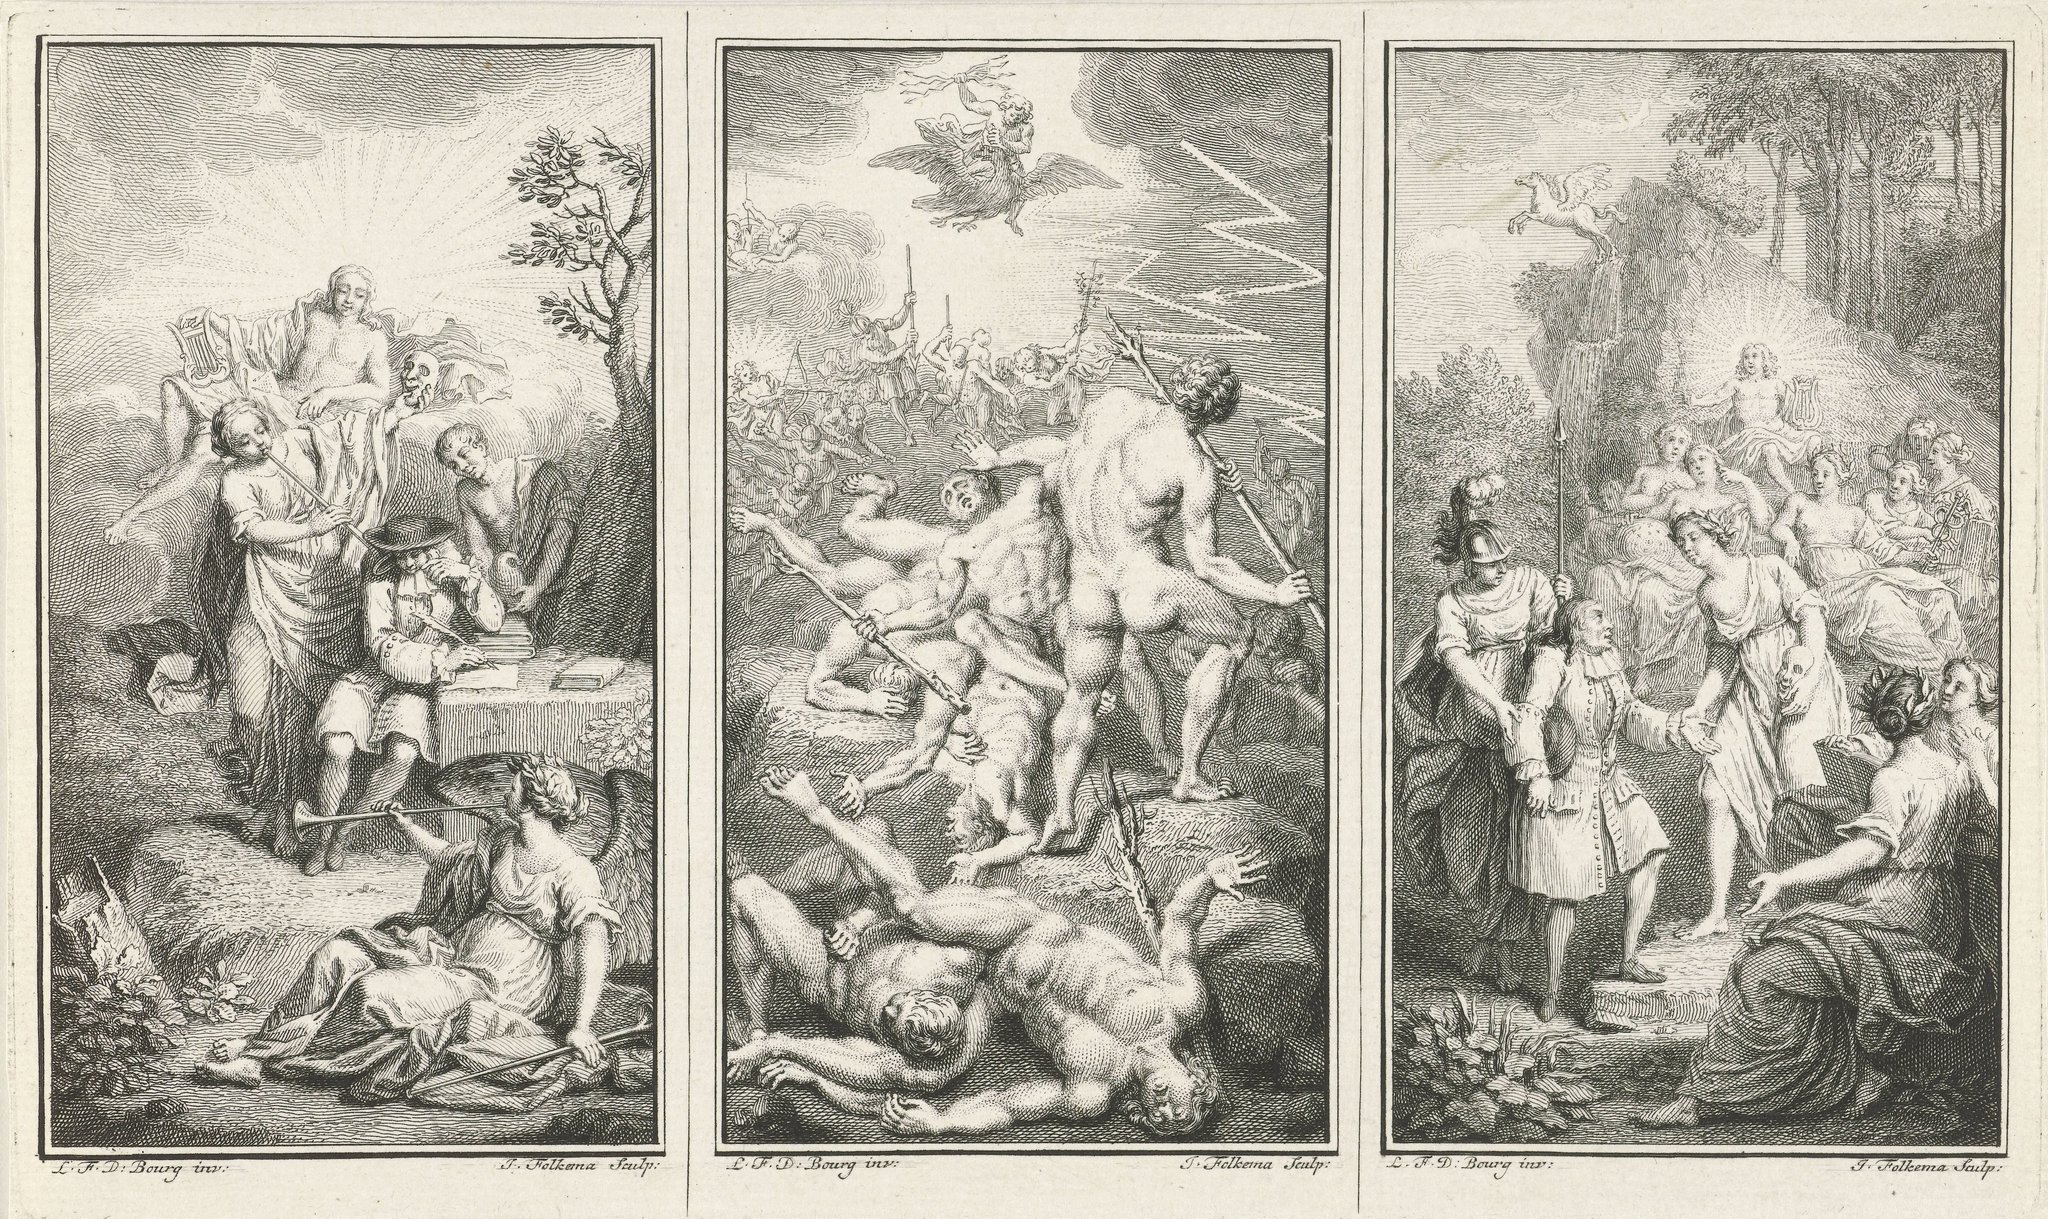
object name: book illustration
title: Mythologische en allegorische voorstellingen op de inspiratie van de toneelschrijver Paul Scarron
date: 1703-1767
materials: paper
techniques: etching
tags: paris, apollo and the muses, apollo musagetes, theatre, theatrical performance, battle of the giants against the gods: gigantomachy, melpomene (one of the muses); 'melpomene' (ripa), author, poet writing (+ inspiration)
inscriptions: collector's mark: Lugt 240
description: Eén mythologische en twee allegorische voorstellingen, vervaardigd voor een boekuitgave van de theaterstukken van Paul Scarron. Links: De schrijvende Scarron wordt omringd door Melpomene (met masker) en een gelauwerde engel die beide de bazuin blazen, op de achtergrond kijken een jongen met schelp en Apollo met zijn lier toe. Midden: De strijd van de goden en giganten. Rechts: Minerva leidt Scarron naar een plek waar Apollo met zijn negen muzen muziek maakt.